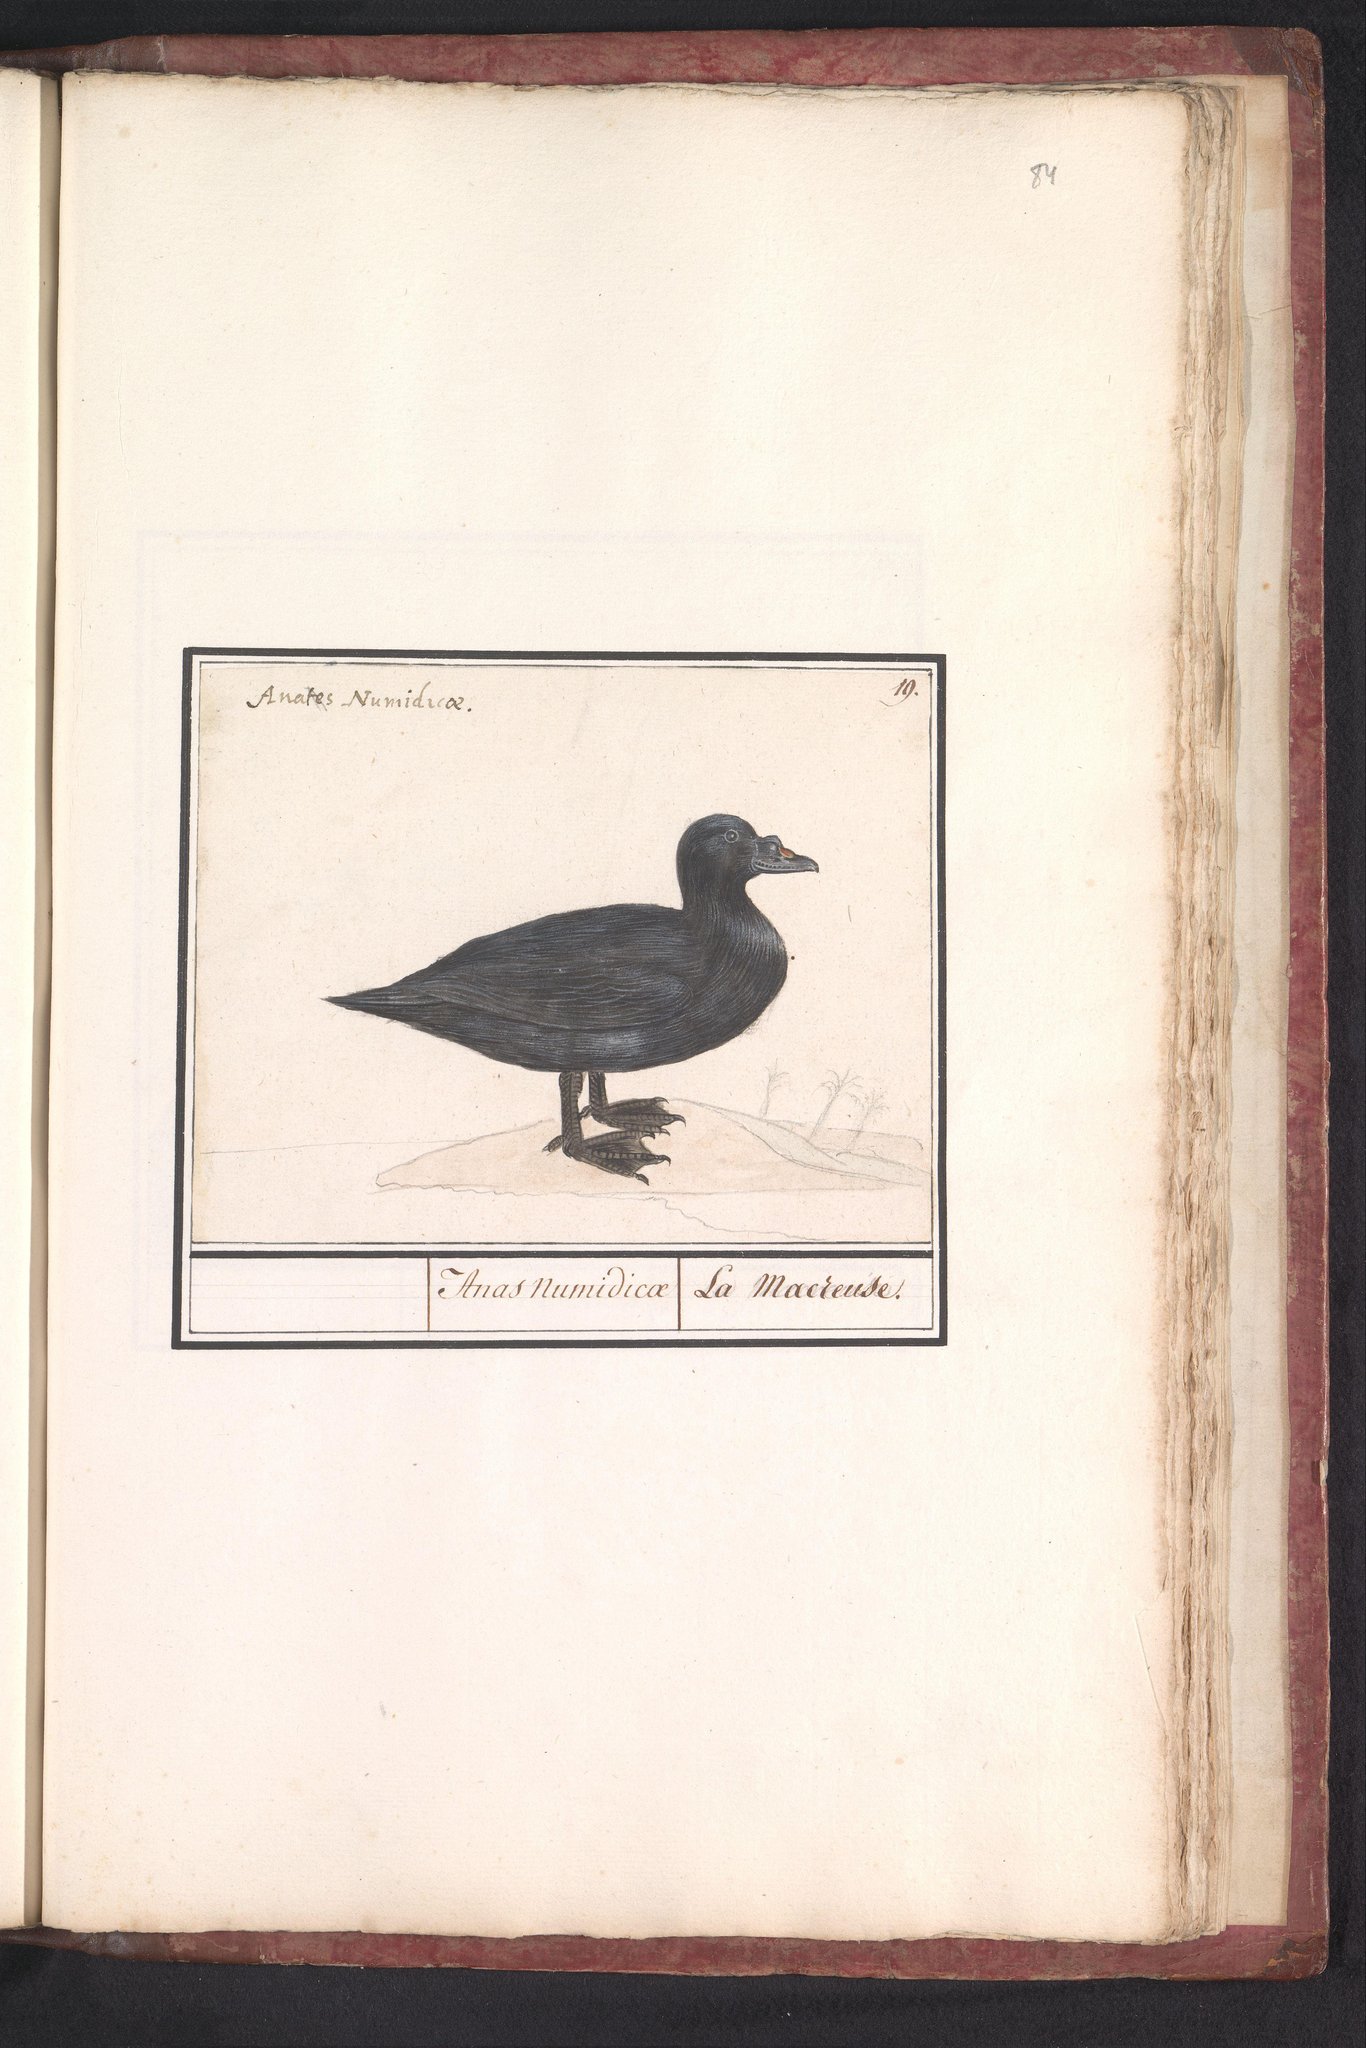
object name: drawing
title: Zwarte zee-eend (Melanitta nigra)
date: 1596-1610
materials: chalk, paint, ink, paper, pencil, watercolor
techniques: brush, pen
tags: water-birds: common scoter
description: Zwarte zee-eend. Genummerd rechtsboven: 19. Linksboven de Latijnse naam. Onderdeel van het derde album met tekeningen van vogels. Vijfde van twaalf albums met tekeningen van dieren, vogels en planten bekend rond 1600, gemaakt in opdracht van keizer Rudolf II. Met toelichting in Nederlands, Latijn en Frans.